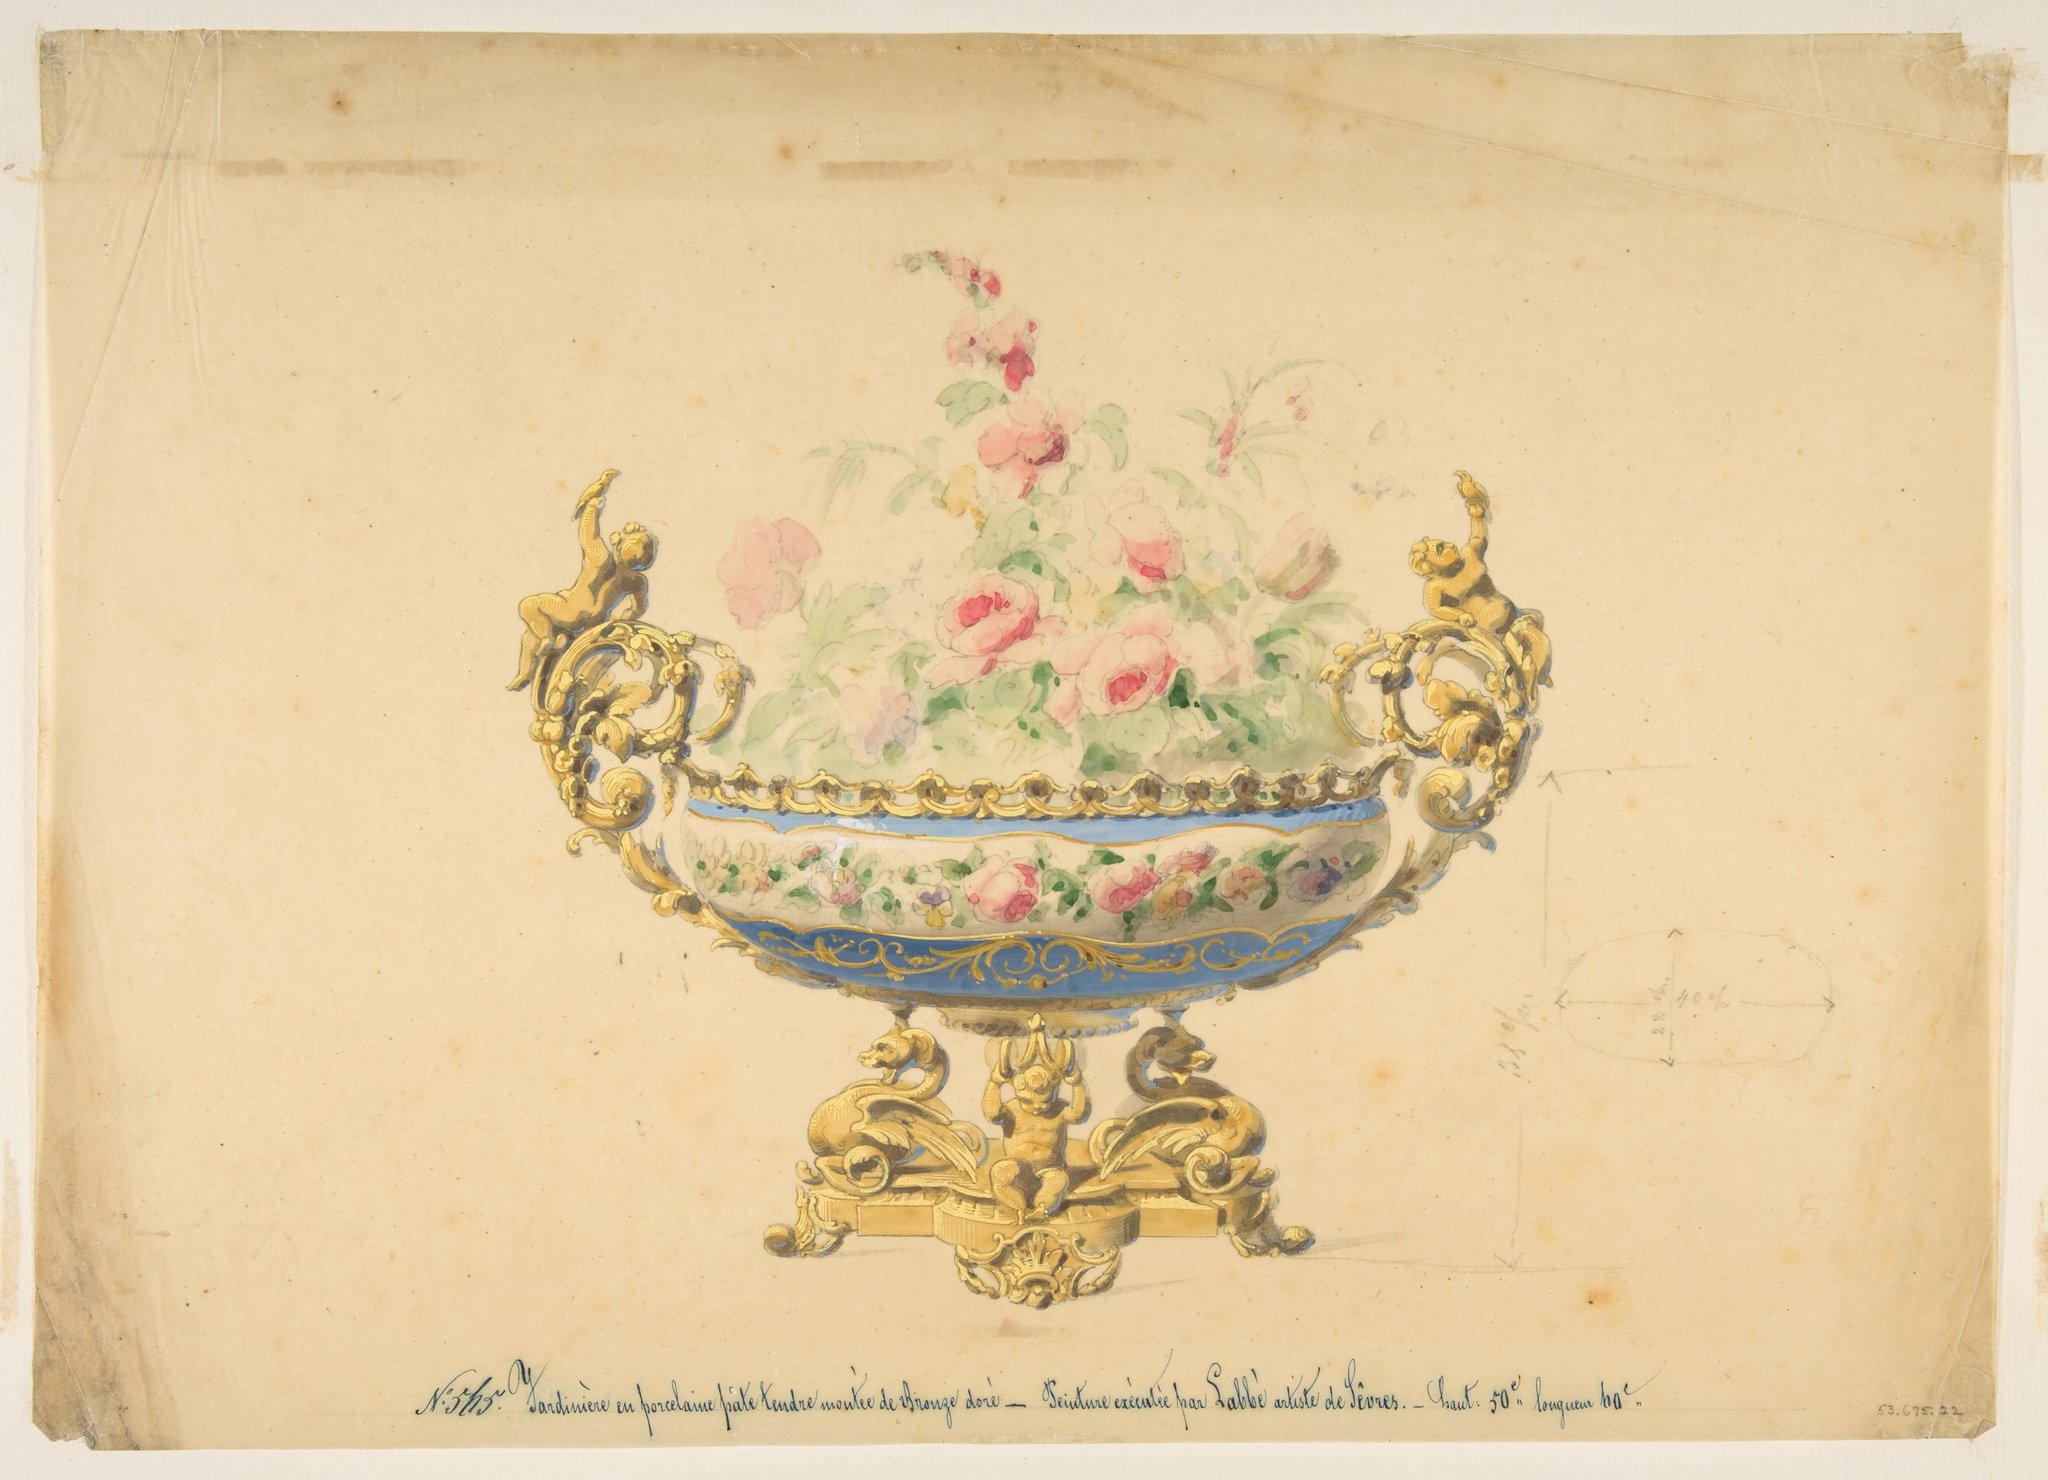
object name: drawing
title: Design for a Jardiniere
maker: anonymous, french, 19th century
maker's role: artist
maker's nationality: french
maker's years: 1800-1900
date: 1801-1900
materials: gilt, gold, gouache, graphite, watercolor